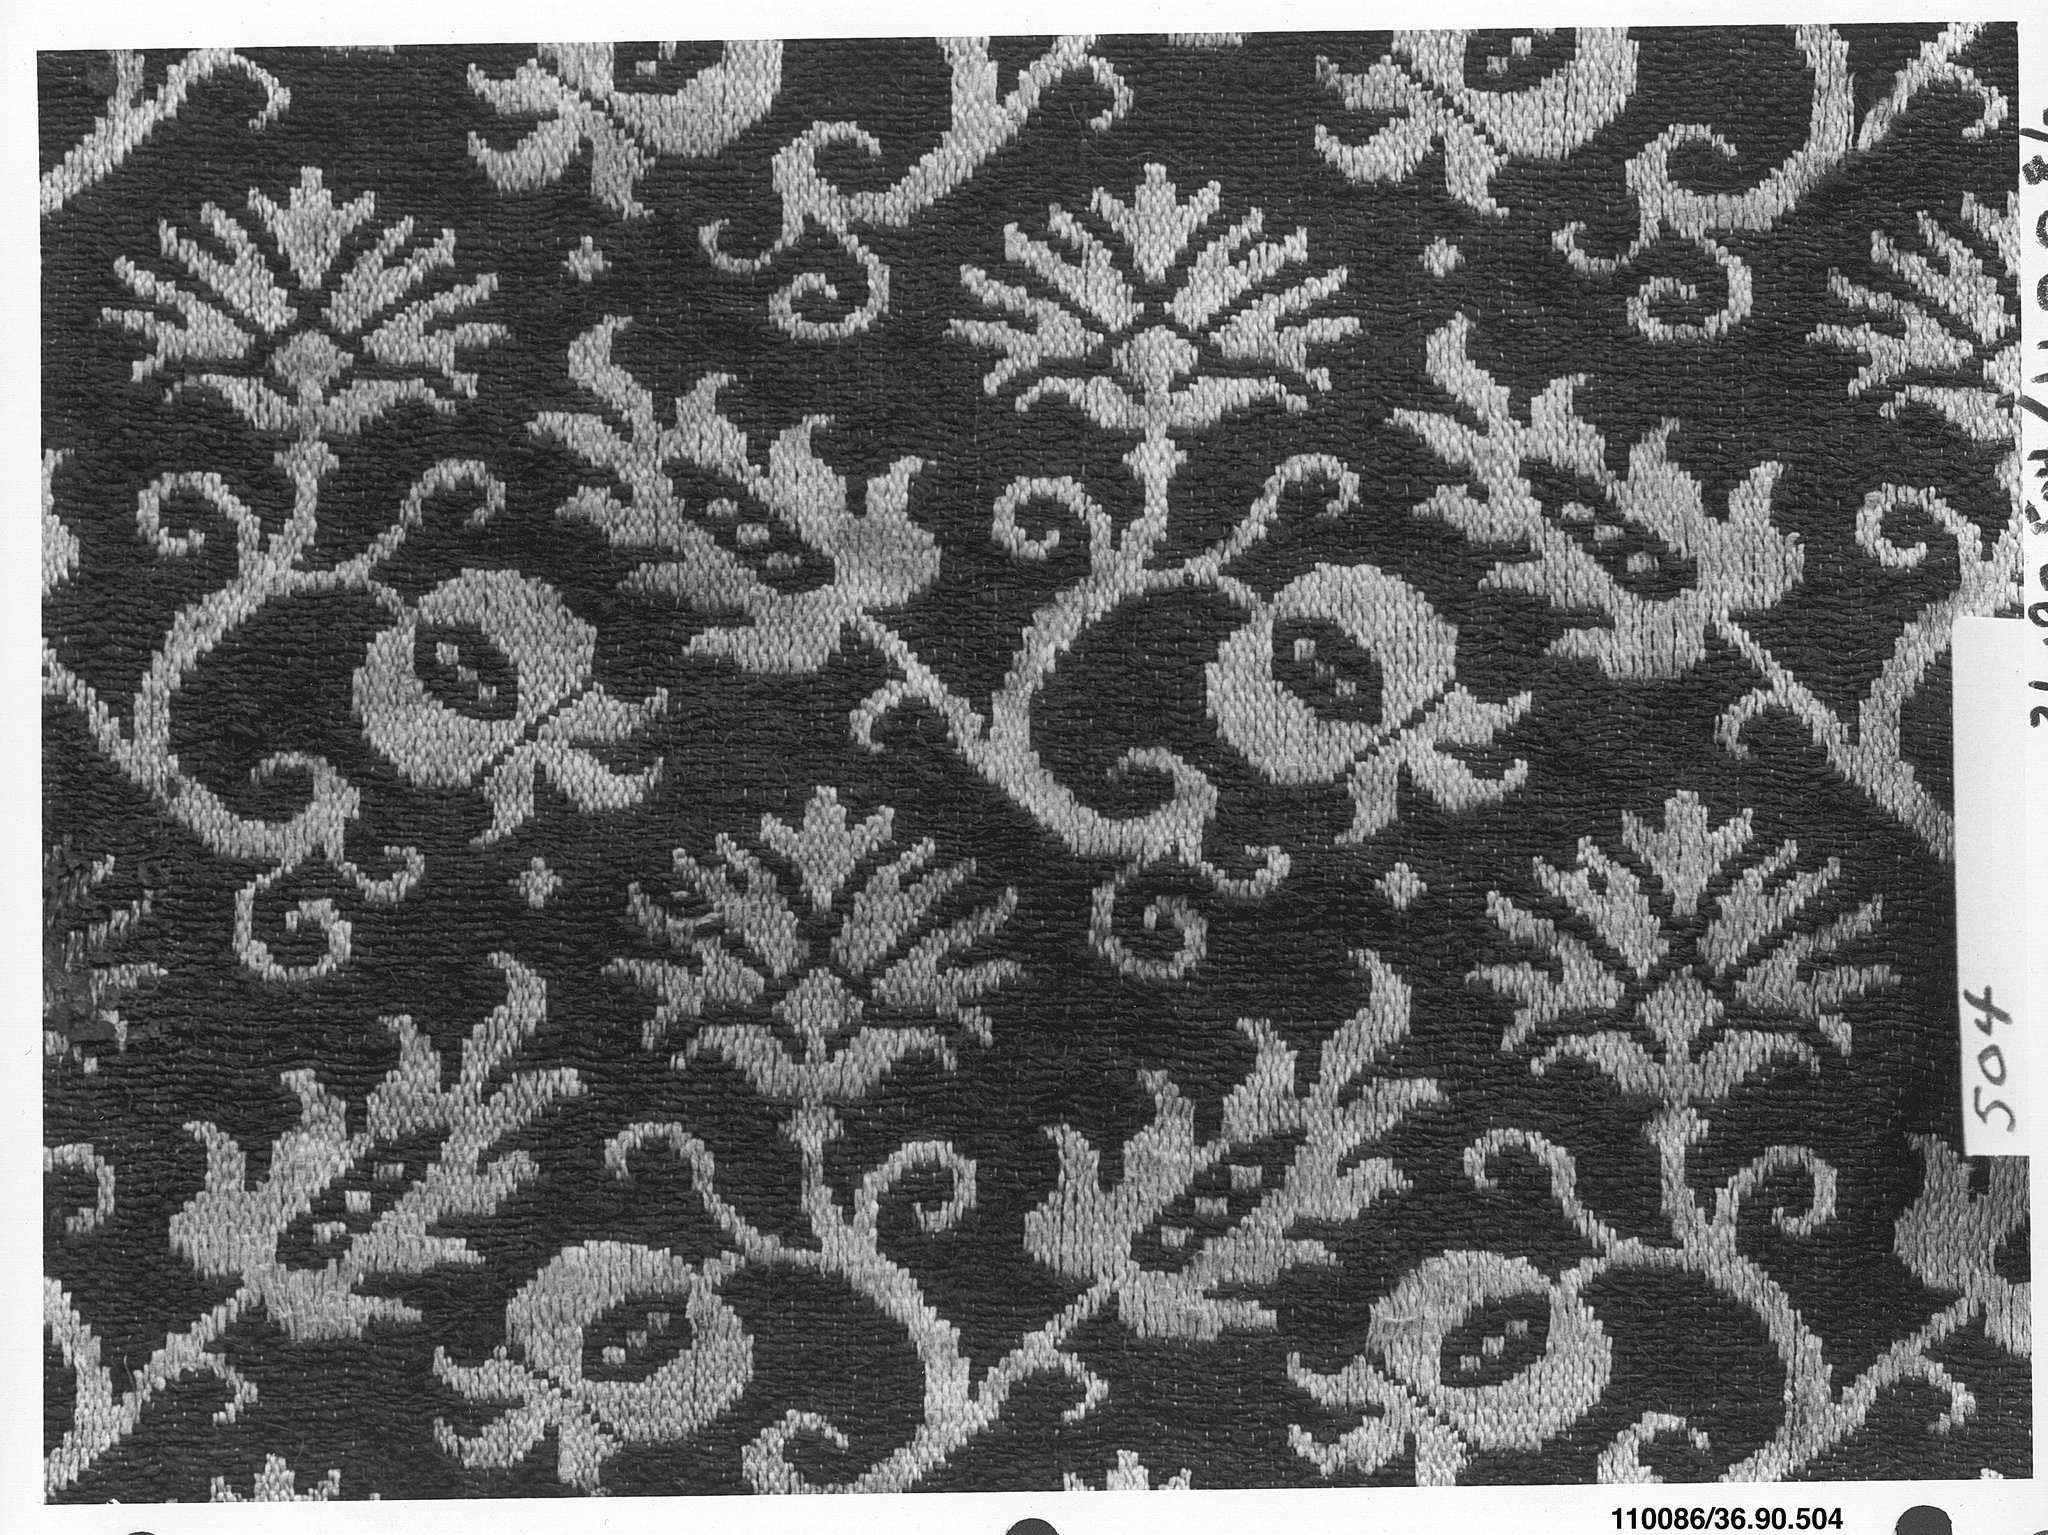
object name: piece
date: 1701-1800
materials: linen, wool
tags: flowers